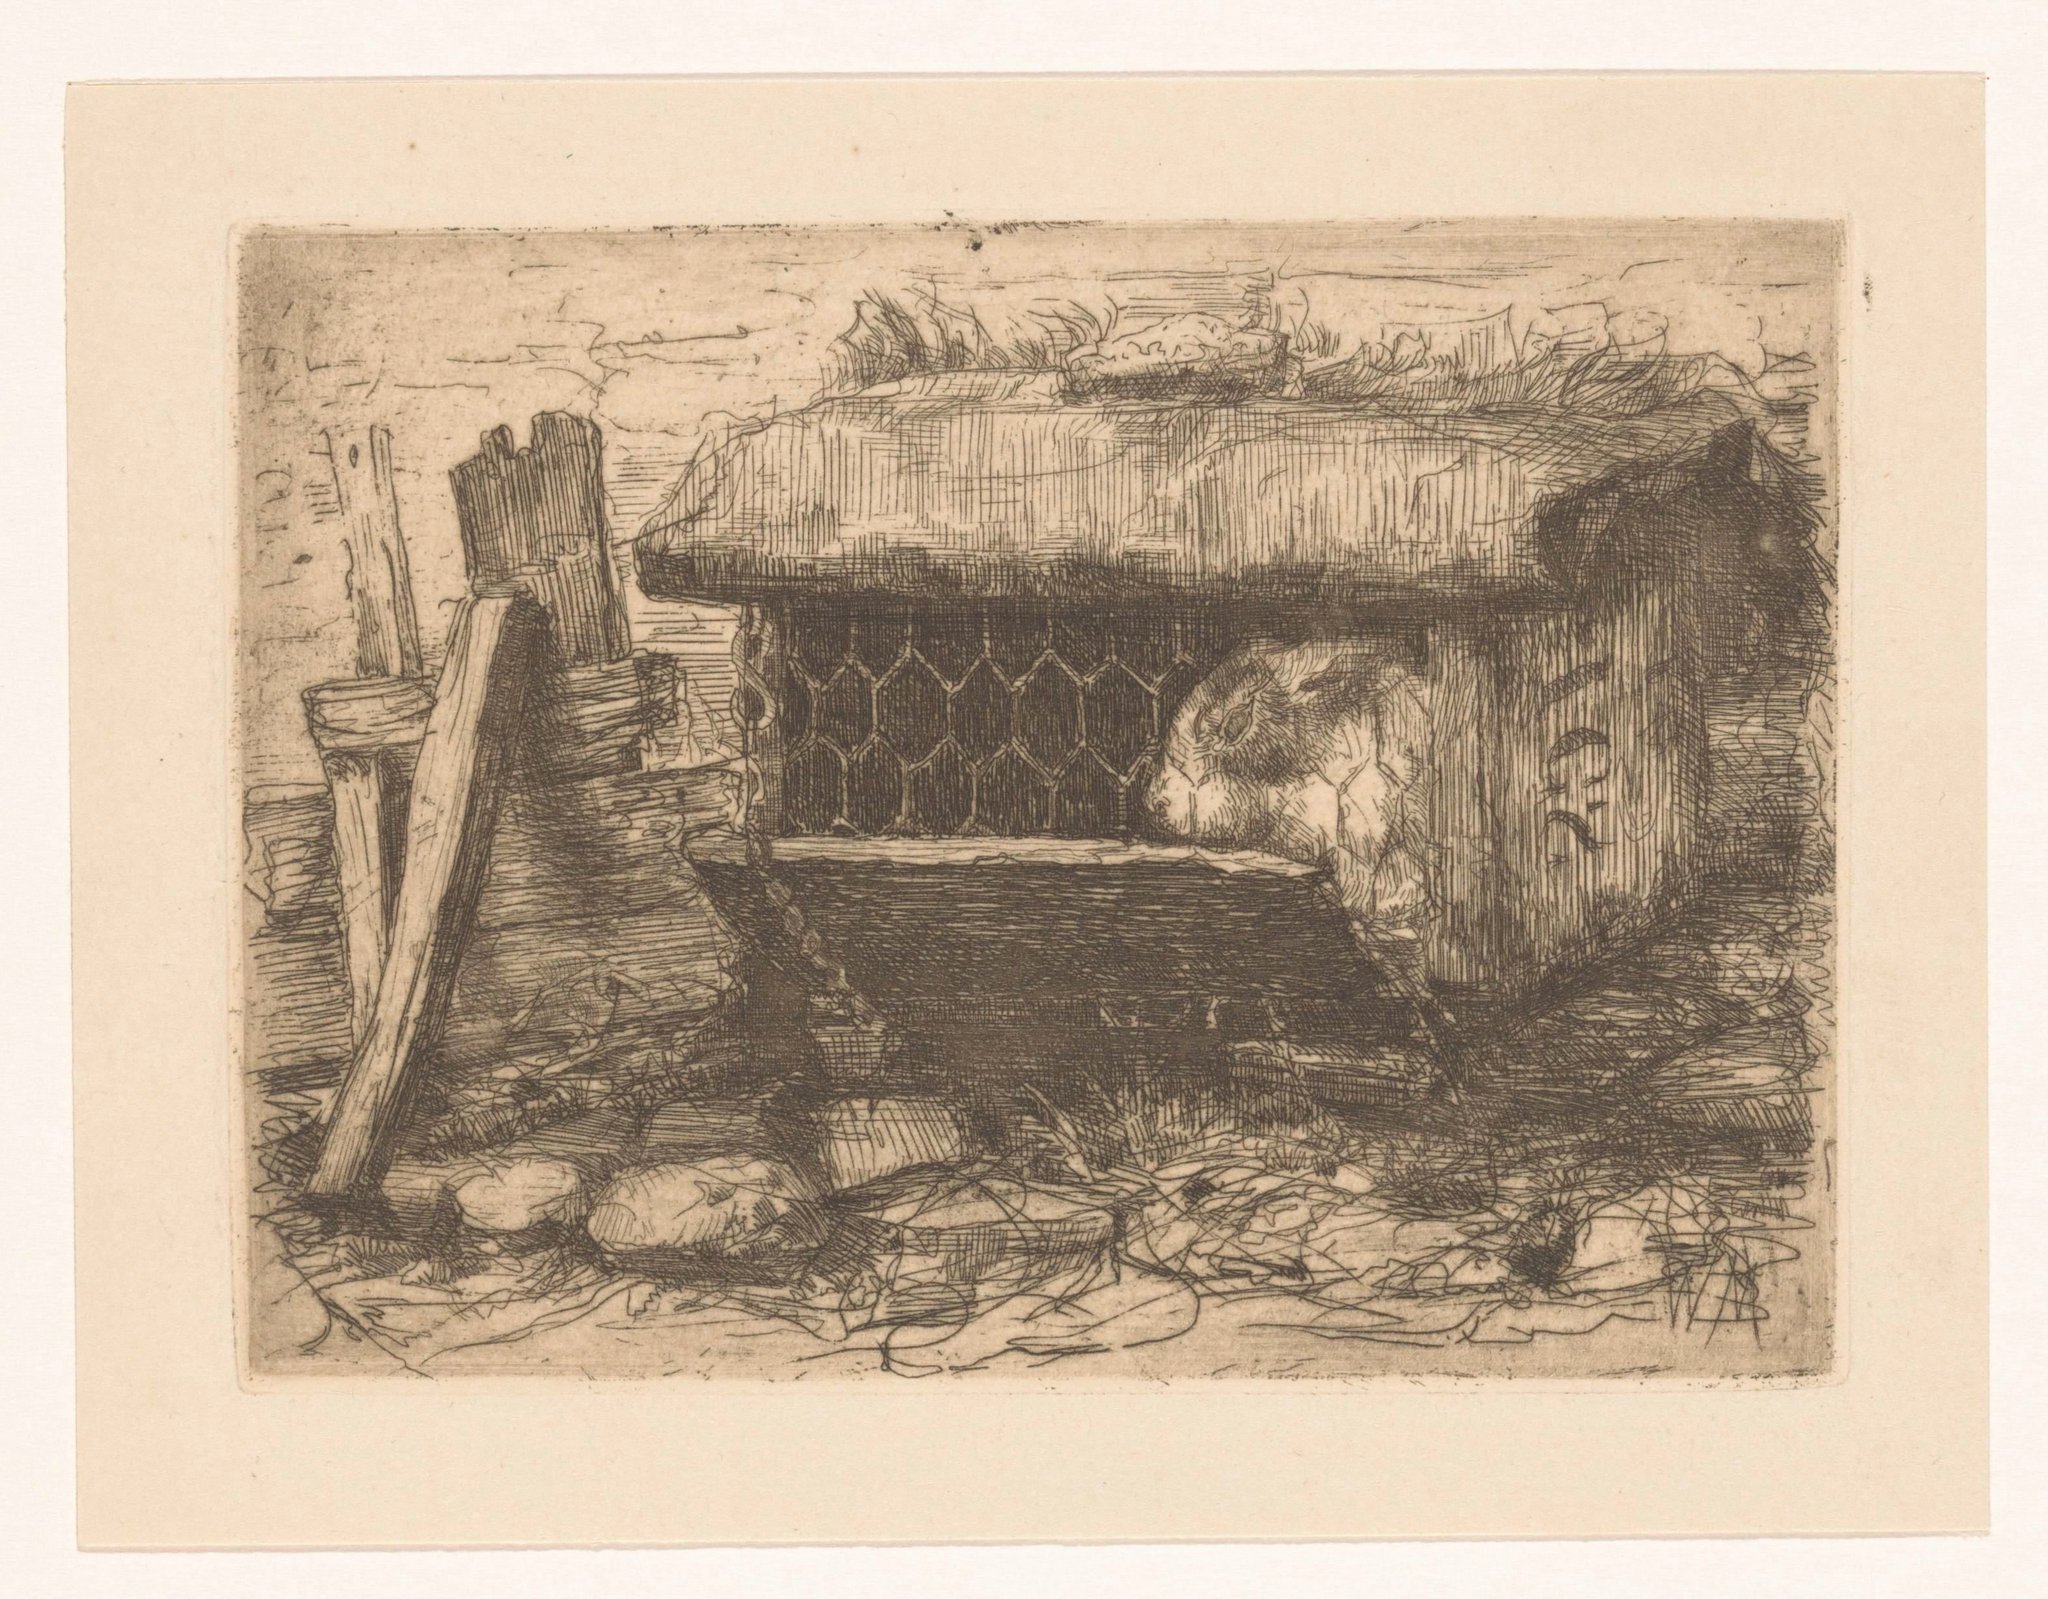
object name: print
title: Konijnenhok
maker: wally moes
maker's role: draughtsman, print maker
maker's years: 1856-1918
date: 1866-1918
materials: paper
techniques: etching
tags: rodents: rabbit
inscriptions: collector's mark: Lugt 2228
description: In het hok zit een konijn; naast het hok liggen planken.